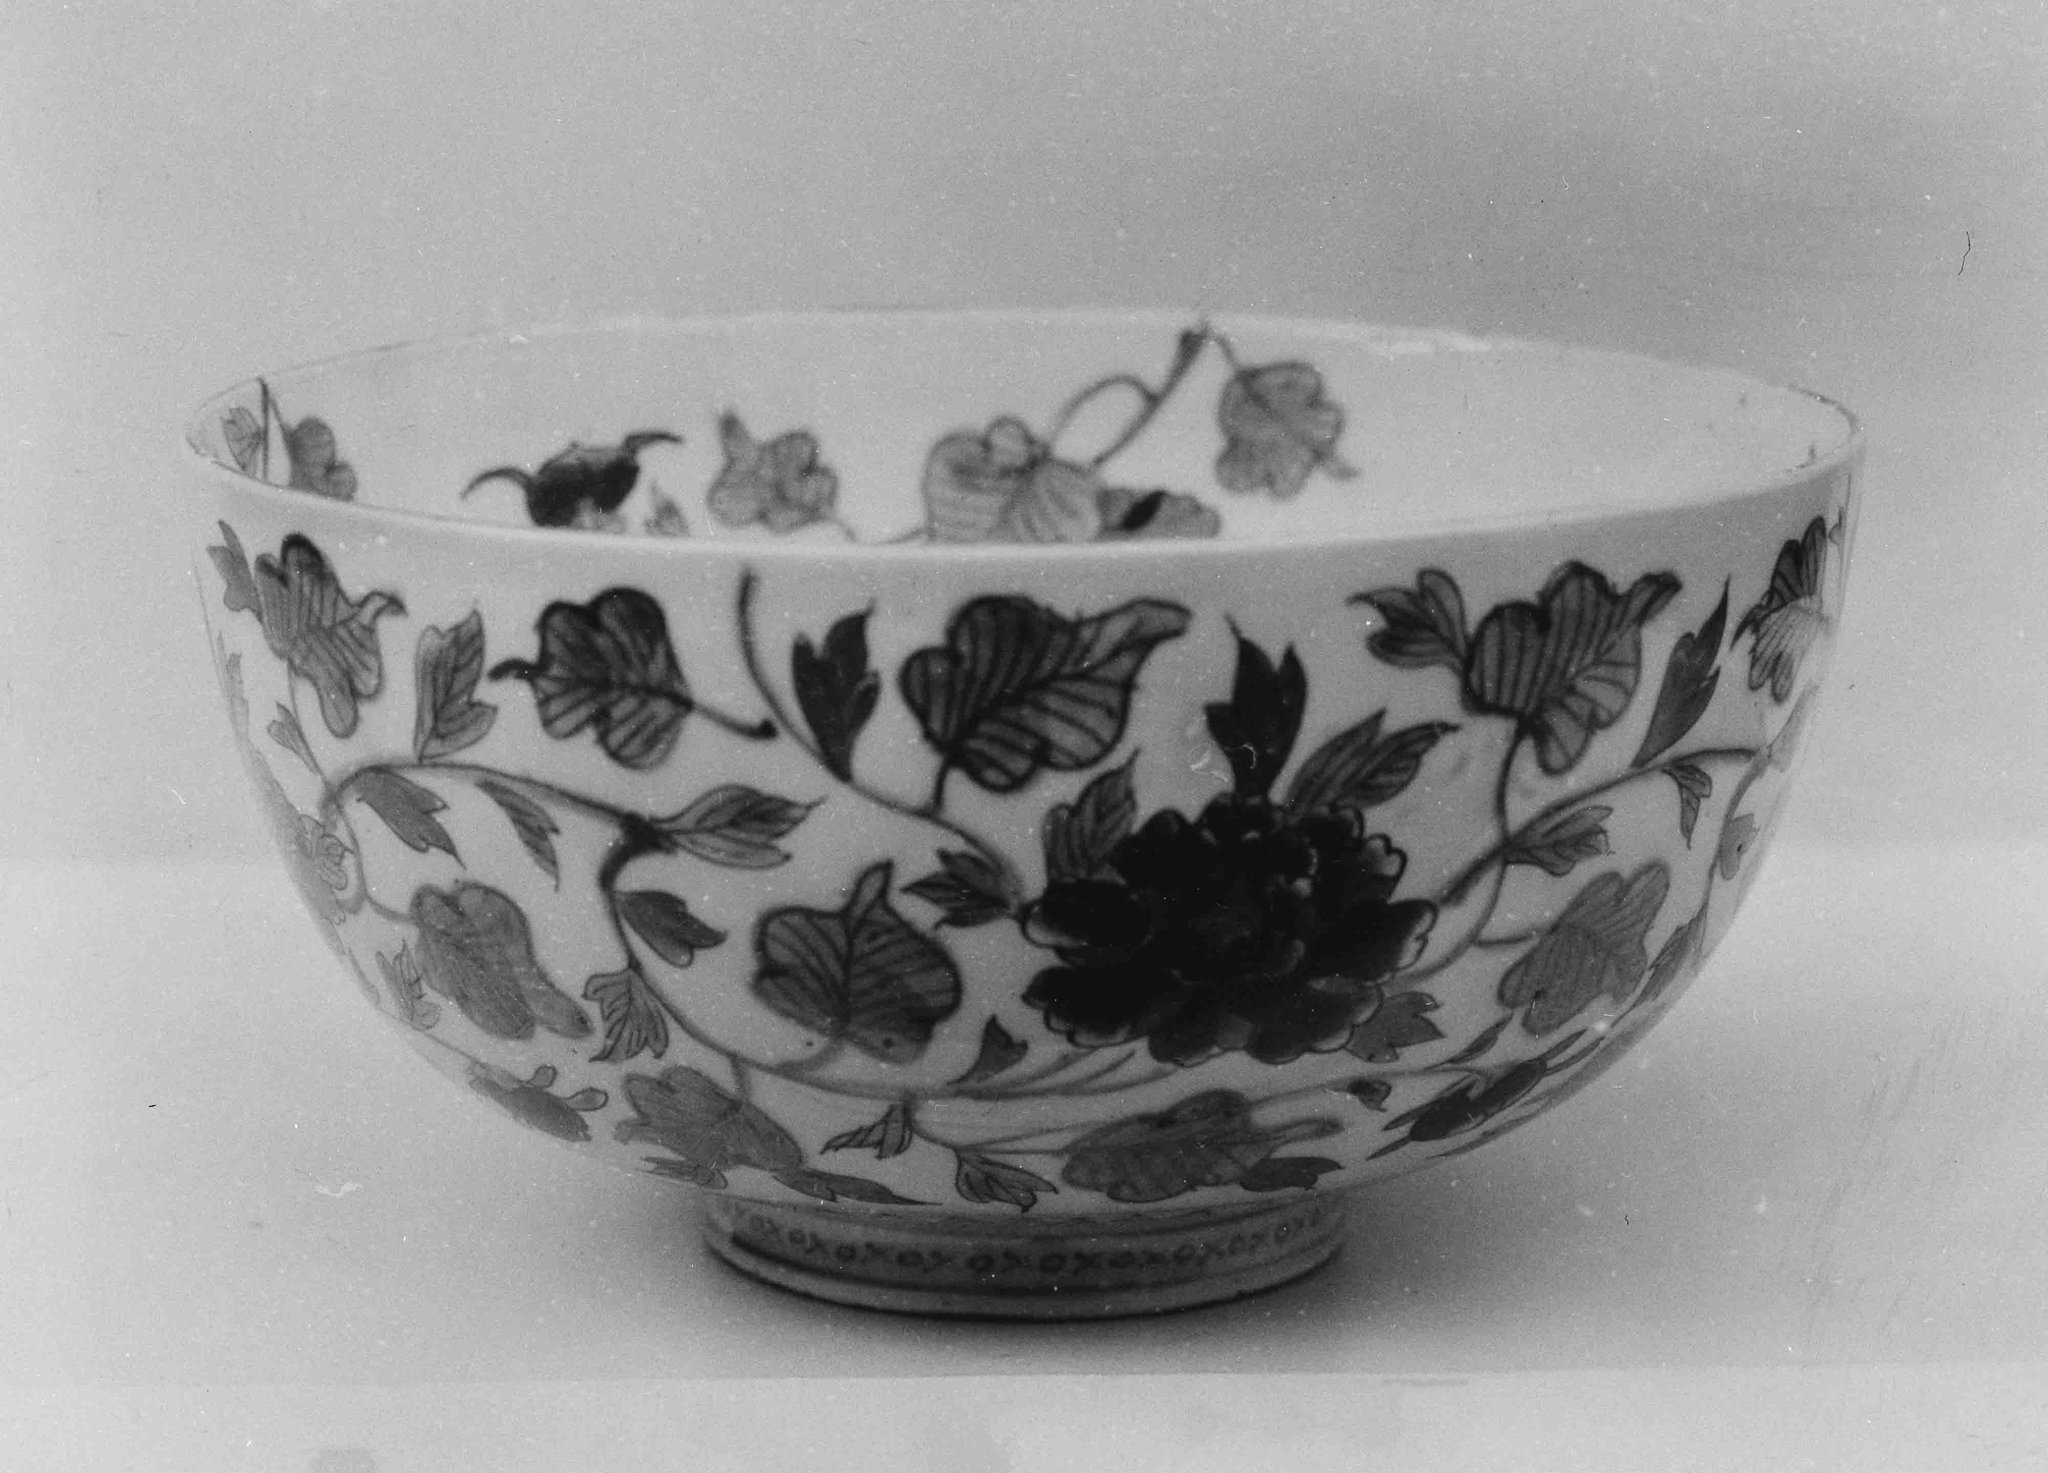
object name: bowl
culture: japanese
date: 1780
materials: enamel, porcelain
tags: flowers,leaves